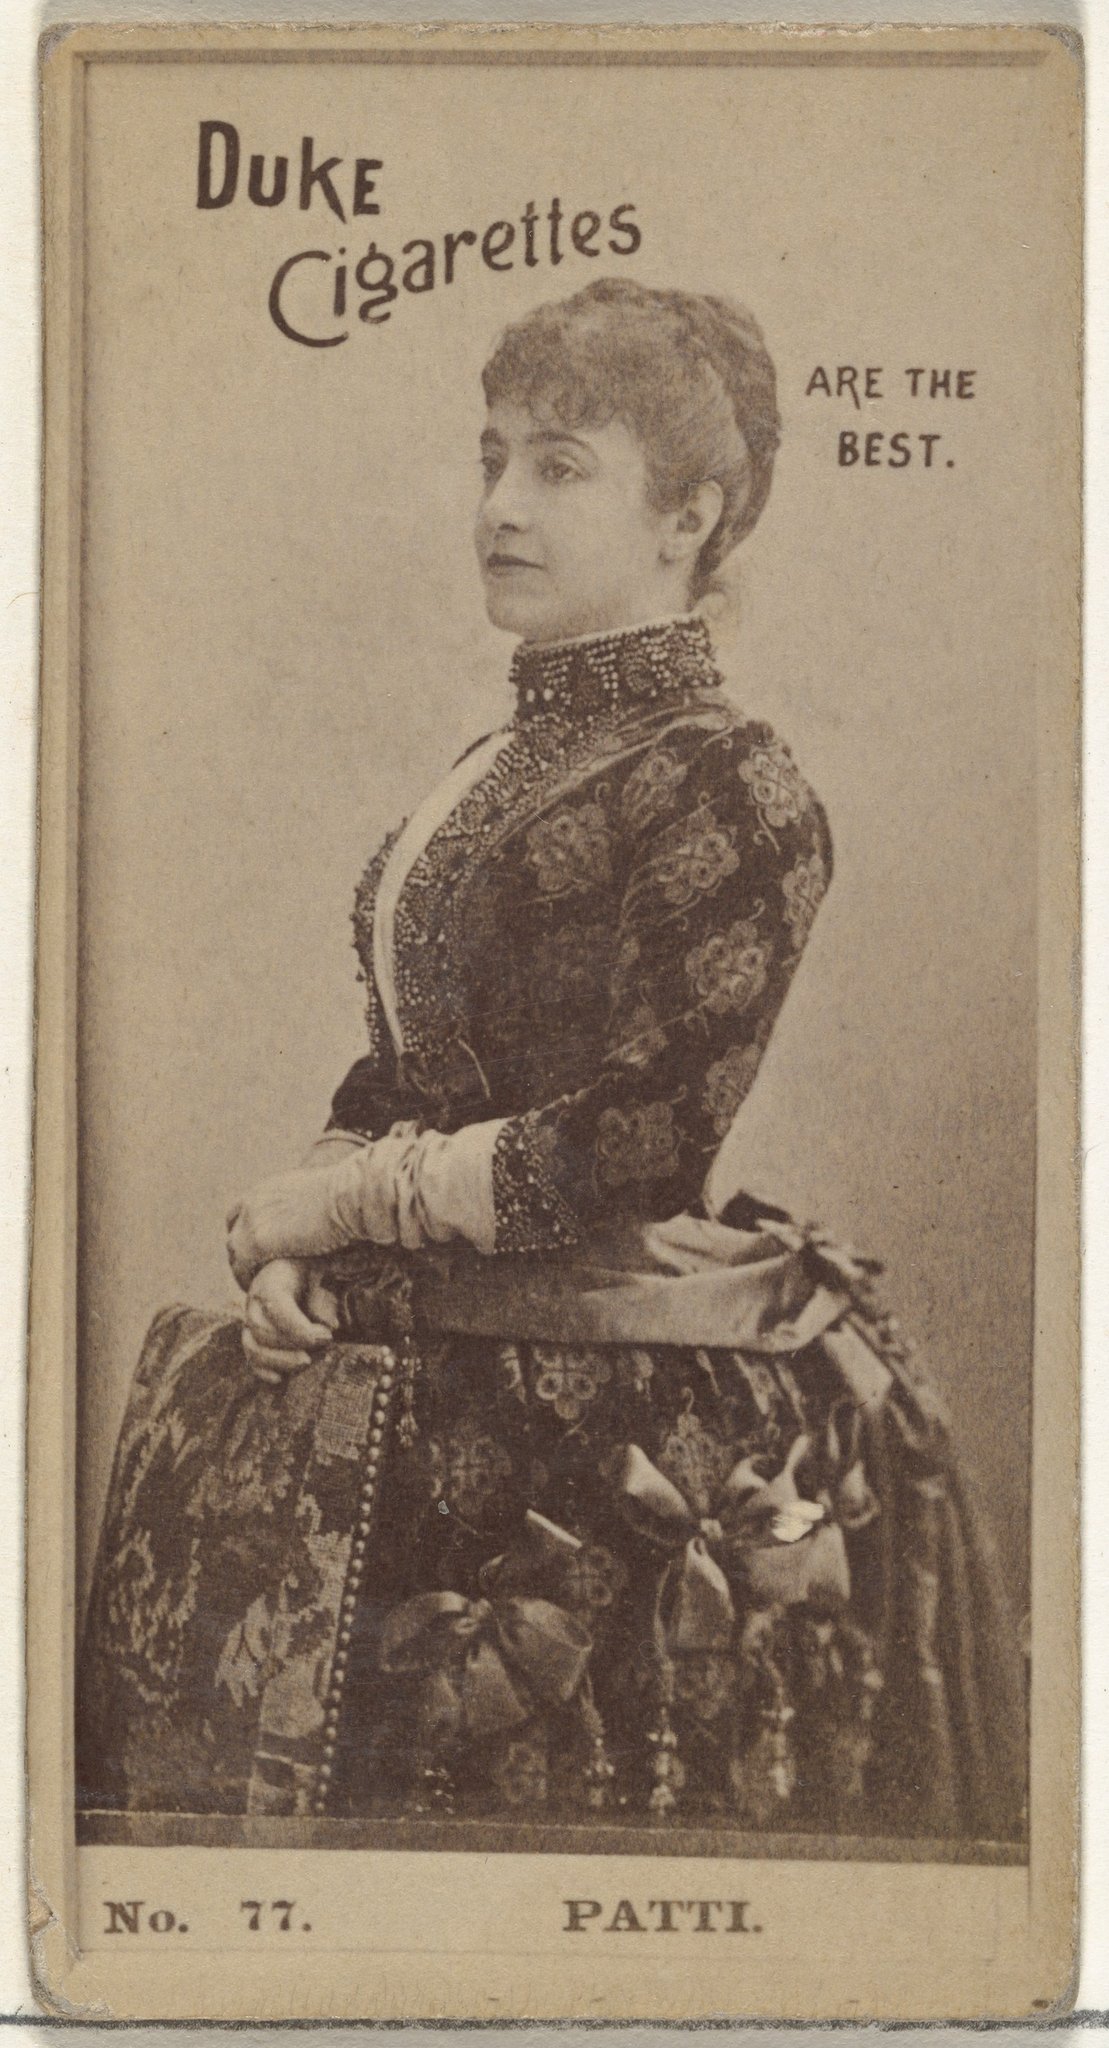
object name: photograph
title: Card Number 77, Patti, from the Actors and Actresses series (N145-6) issued by Duke Sons & Co. to promote Duke Cigarettes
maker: w. duke, sons & co.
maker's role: publisher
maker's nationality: american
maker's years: 1870-1920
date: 1880-1889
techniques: albumen silver print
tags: portraits,women,actresses